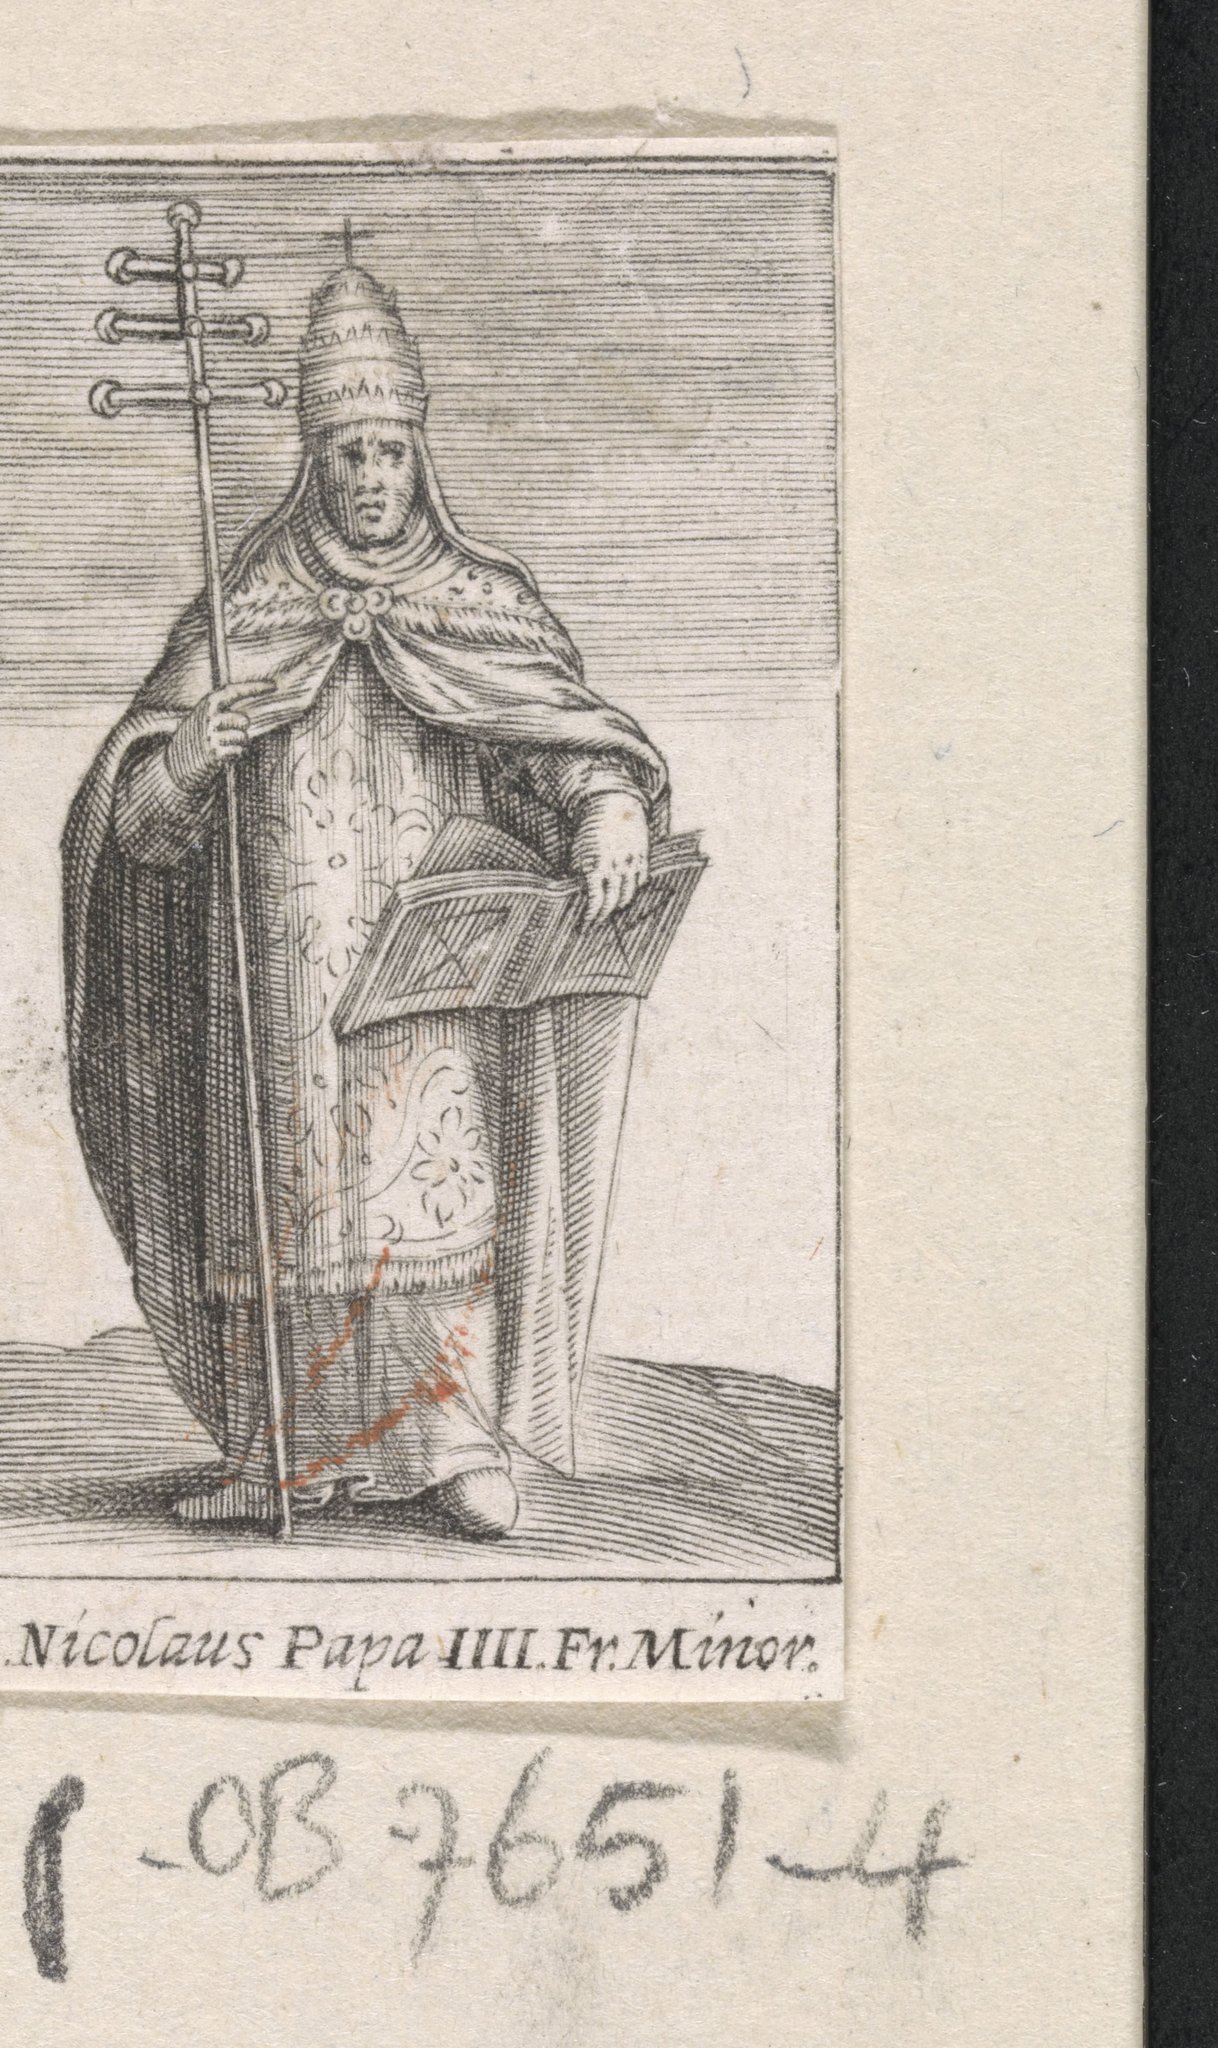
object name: print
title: Portret van paus Nicolaas IV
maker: Anonymous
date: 1570-1632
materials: paper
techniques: engraving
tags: pope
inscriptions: collector's mark: Lugt 240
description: Deze prent vormt samen met RP-P-OB-7651-2 t/m RP-P-OB-7651-11 een lijst rondom RP-P-OB-7609.